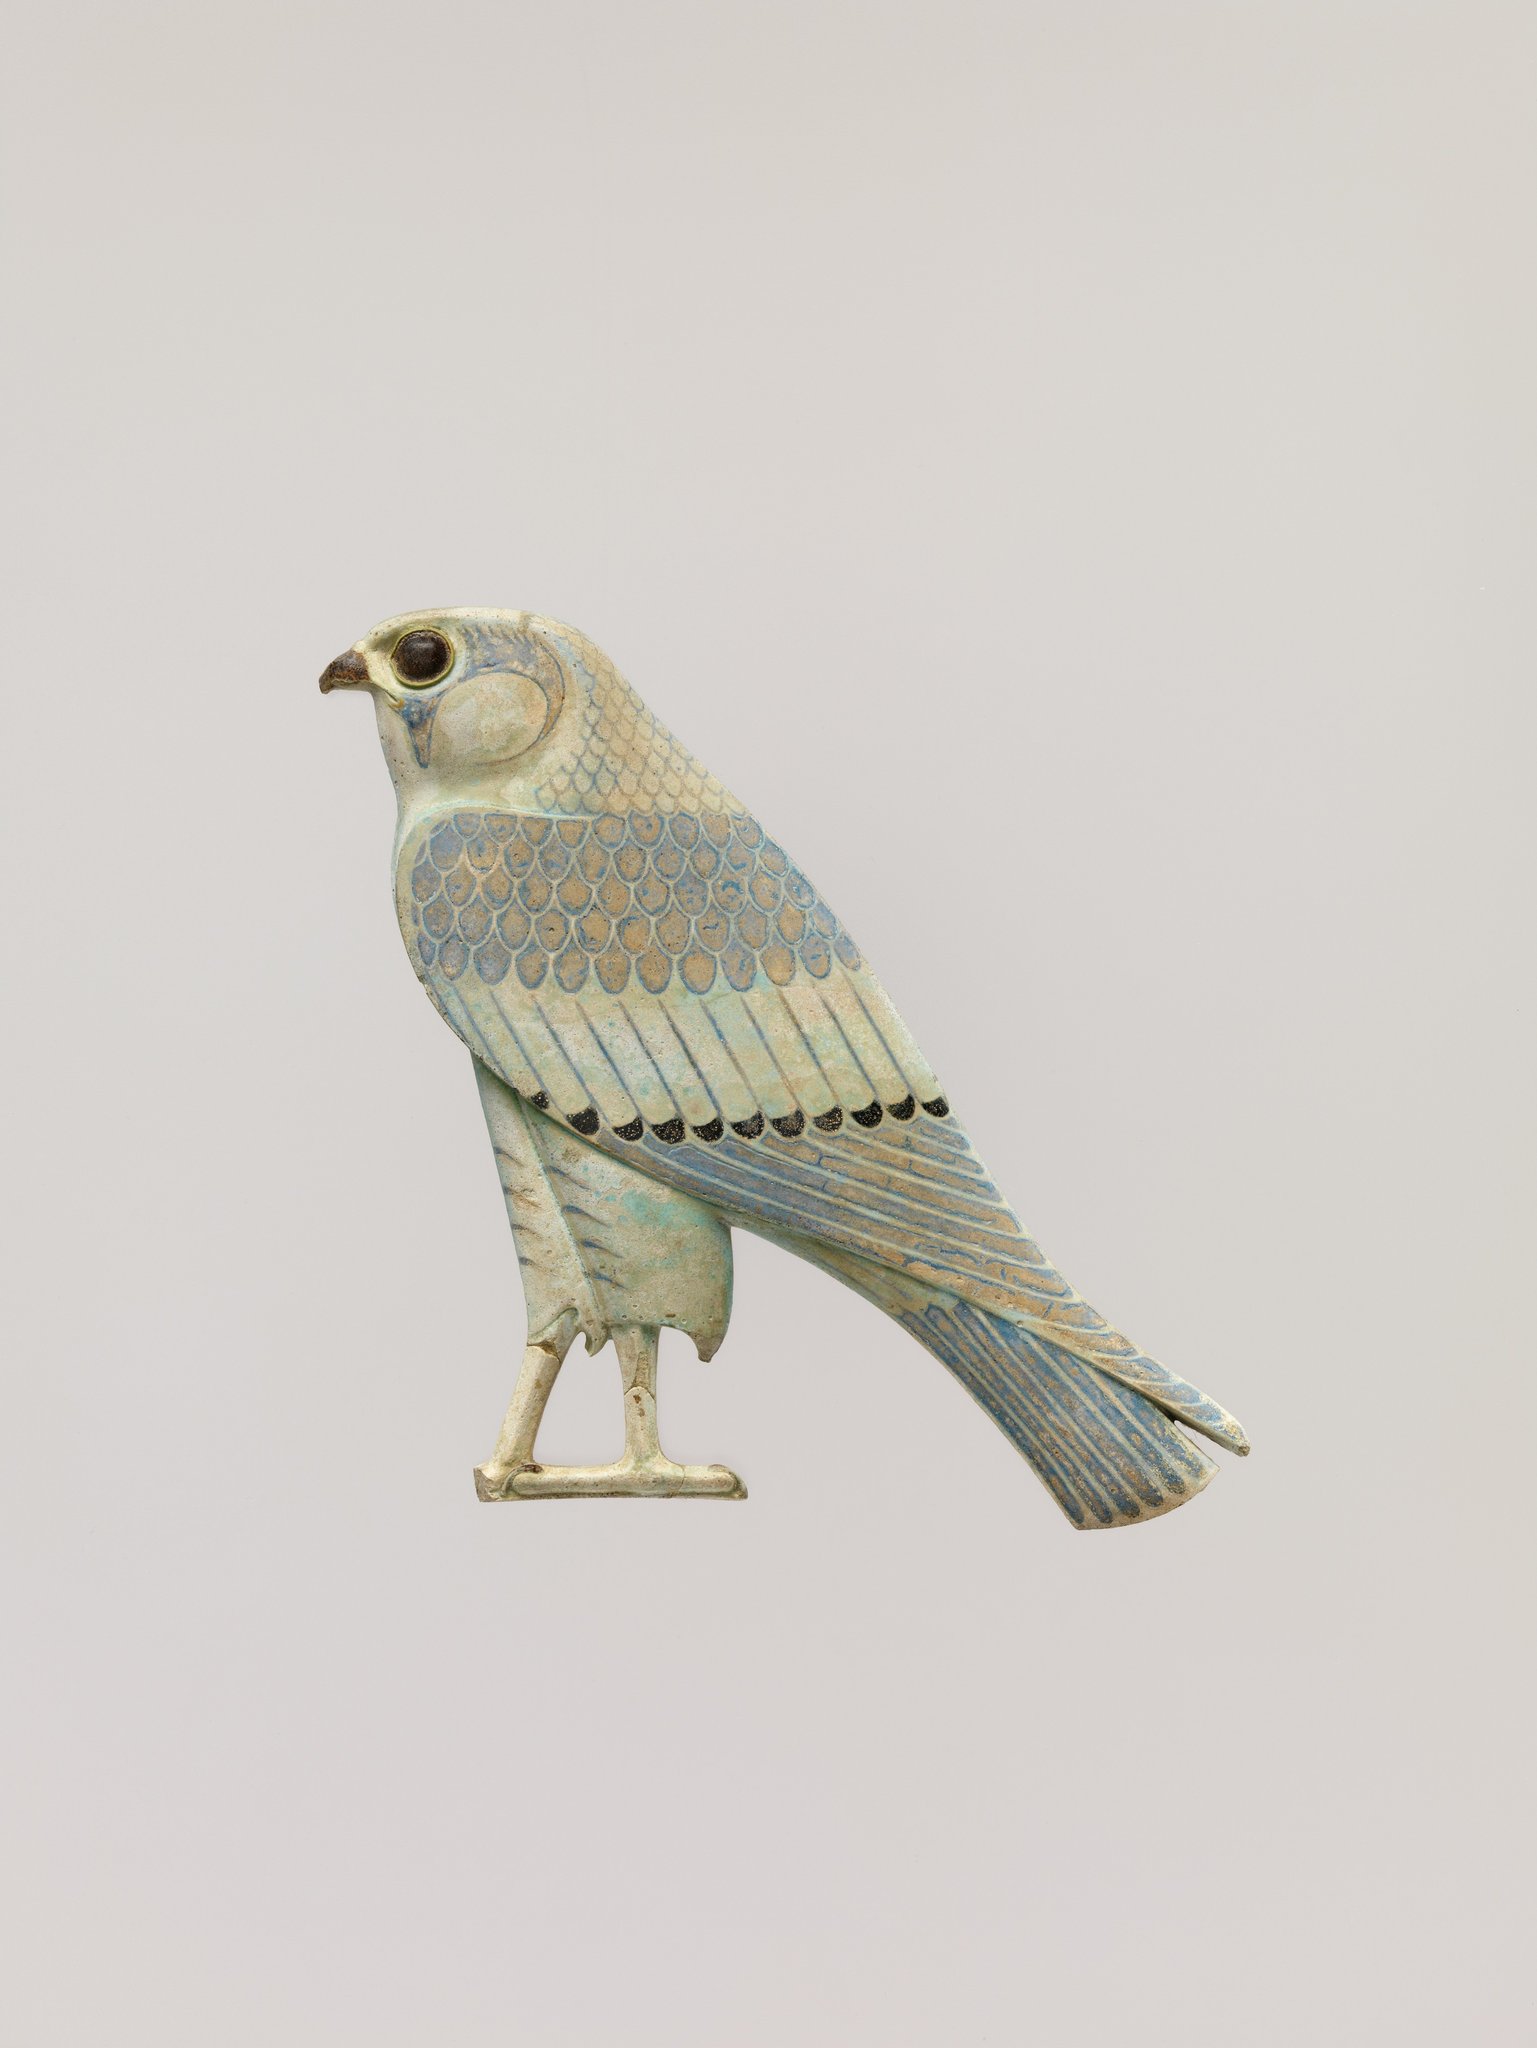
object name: inlay, falcon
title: Inlay depicting a falcon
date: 400-301 BCE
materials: faience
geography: middle egypt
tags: falcons